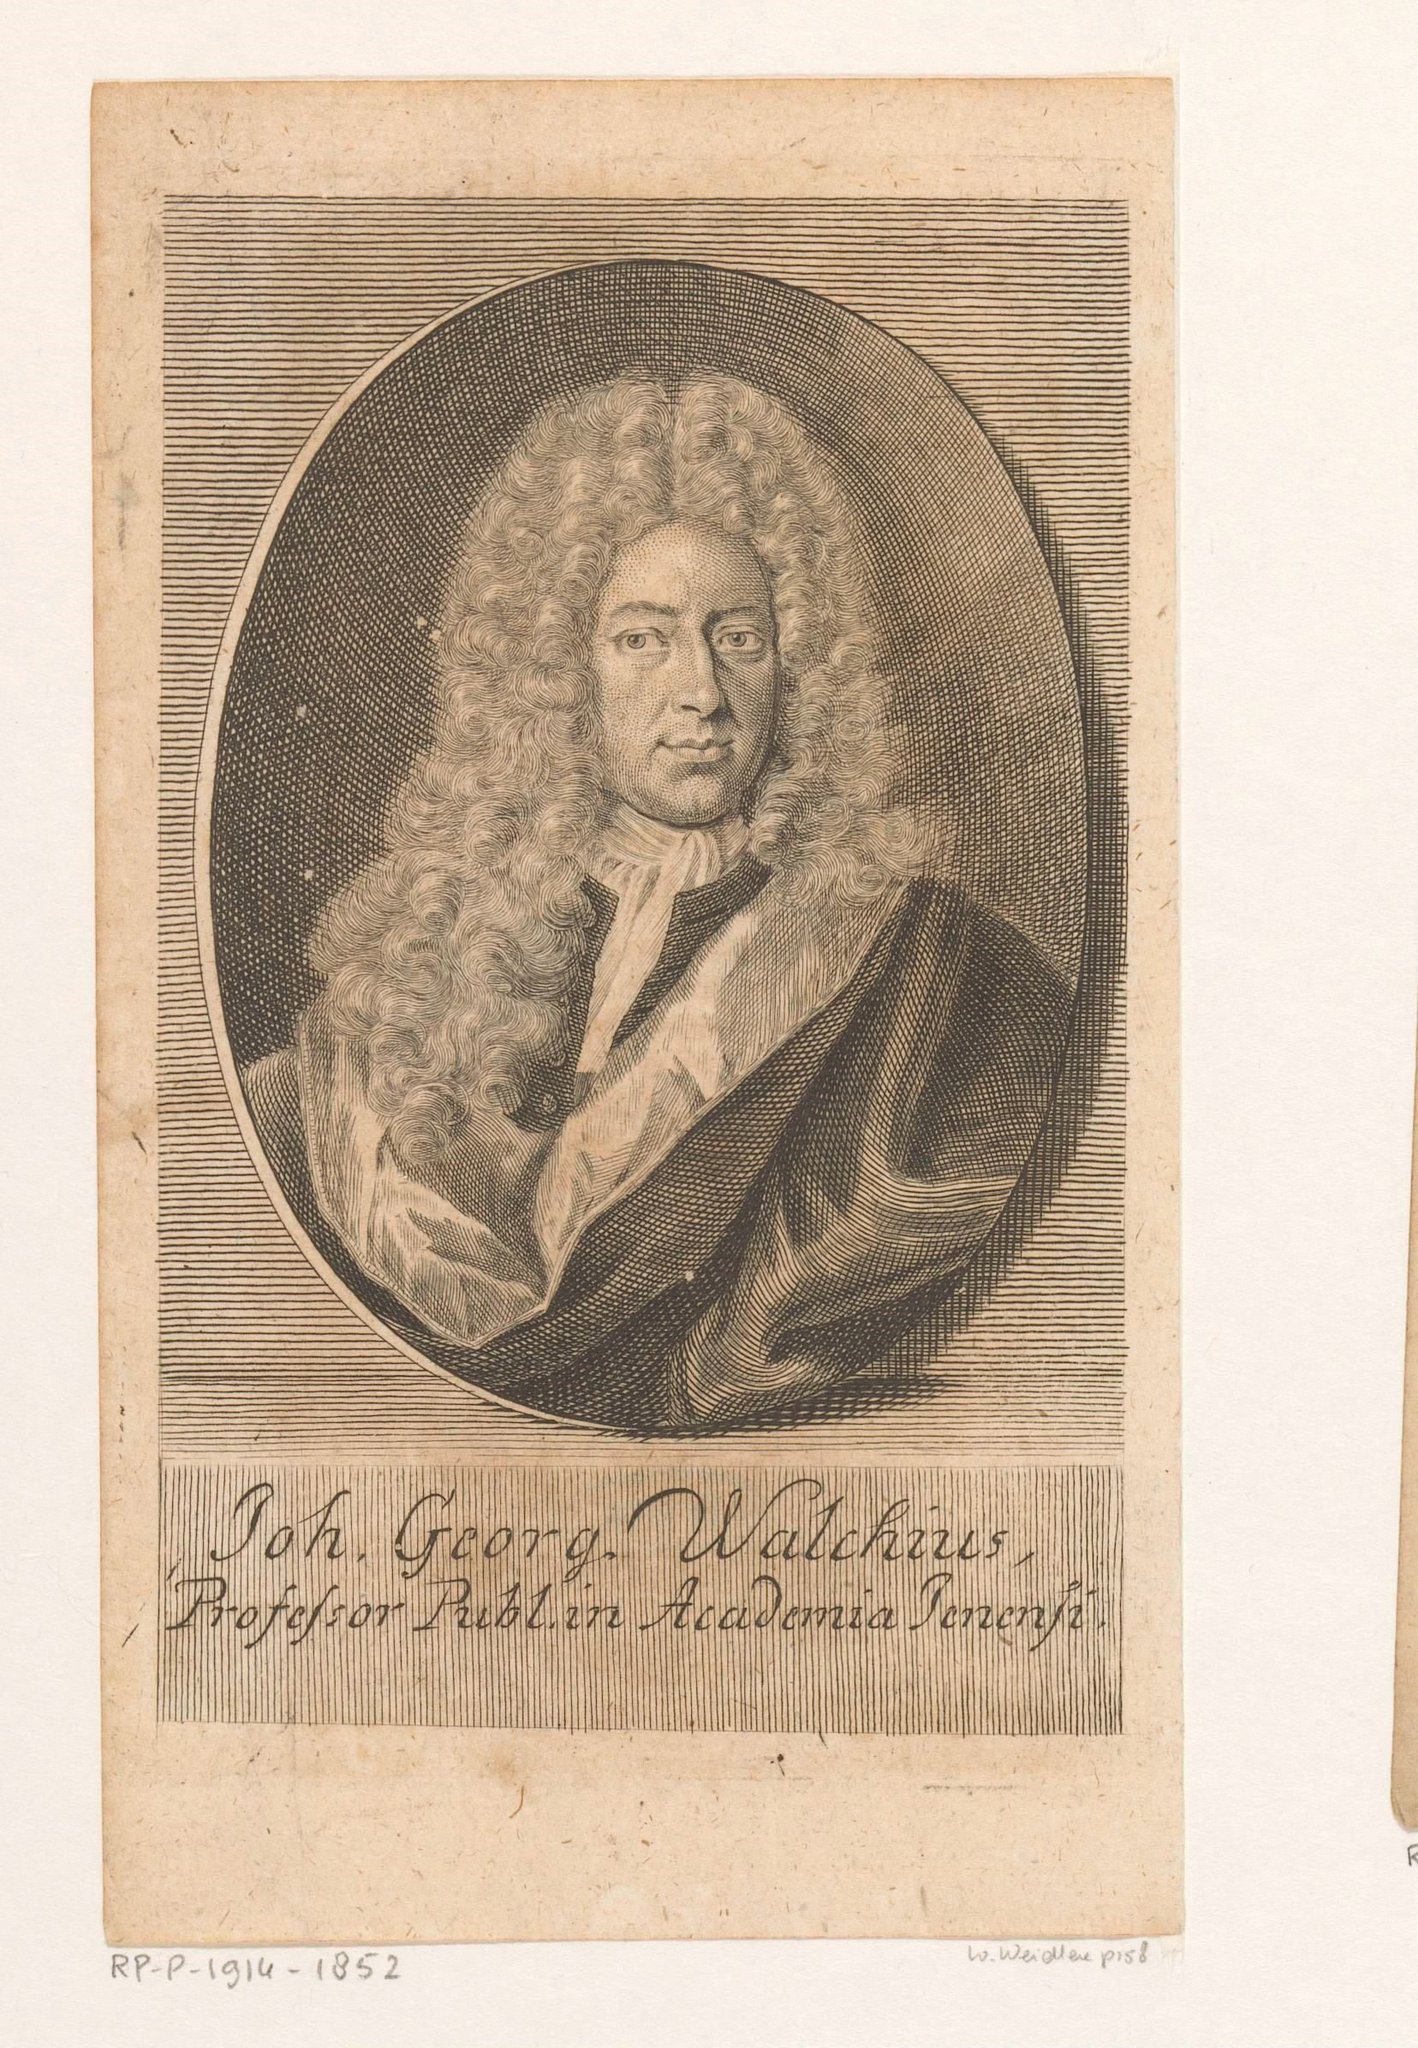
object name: print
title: Portret van Johann Georg Walch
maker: martin bernigeroth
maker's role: print maker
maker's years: 1670-1733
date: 1723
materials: paper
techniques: engraving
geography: leipzig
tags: historical persons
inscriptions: collector's mark: Lugt 2228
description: Prent ook gebruikt in: Deutsche Acta Eruditorum (...). dl. 92. Leipzig: Johann Gottlieb Gleditsch, 1723.